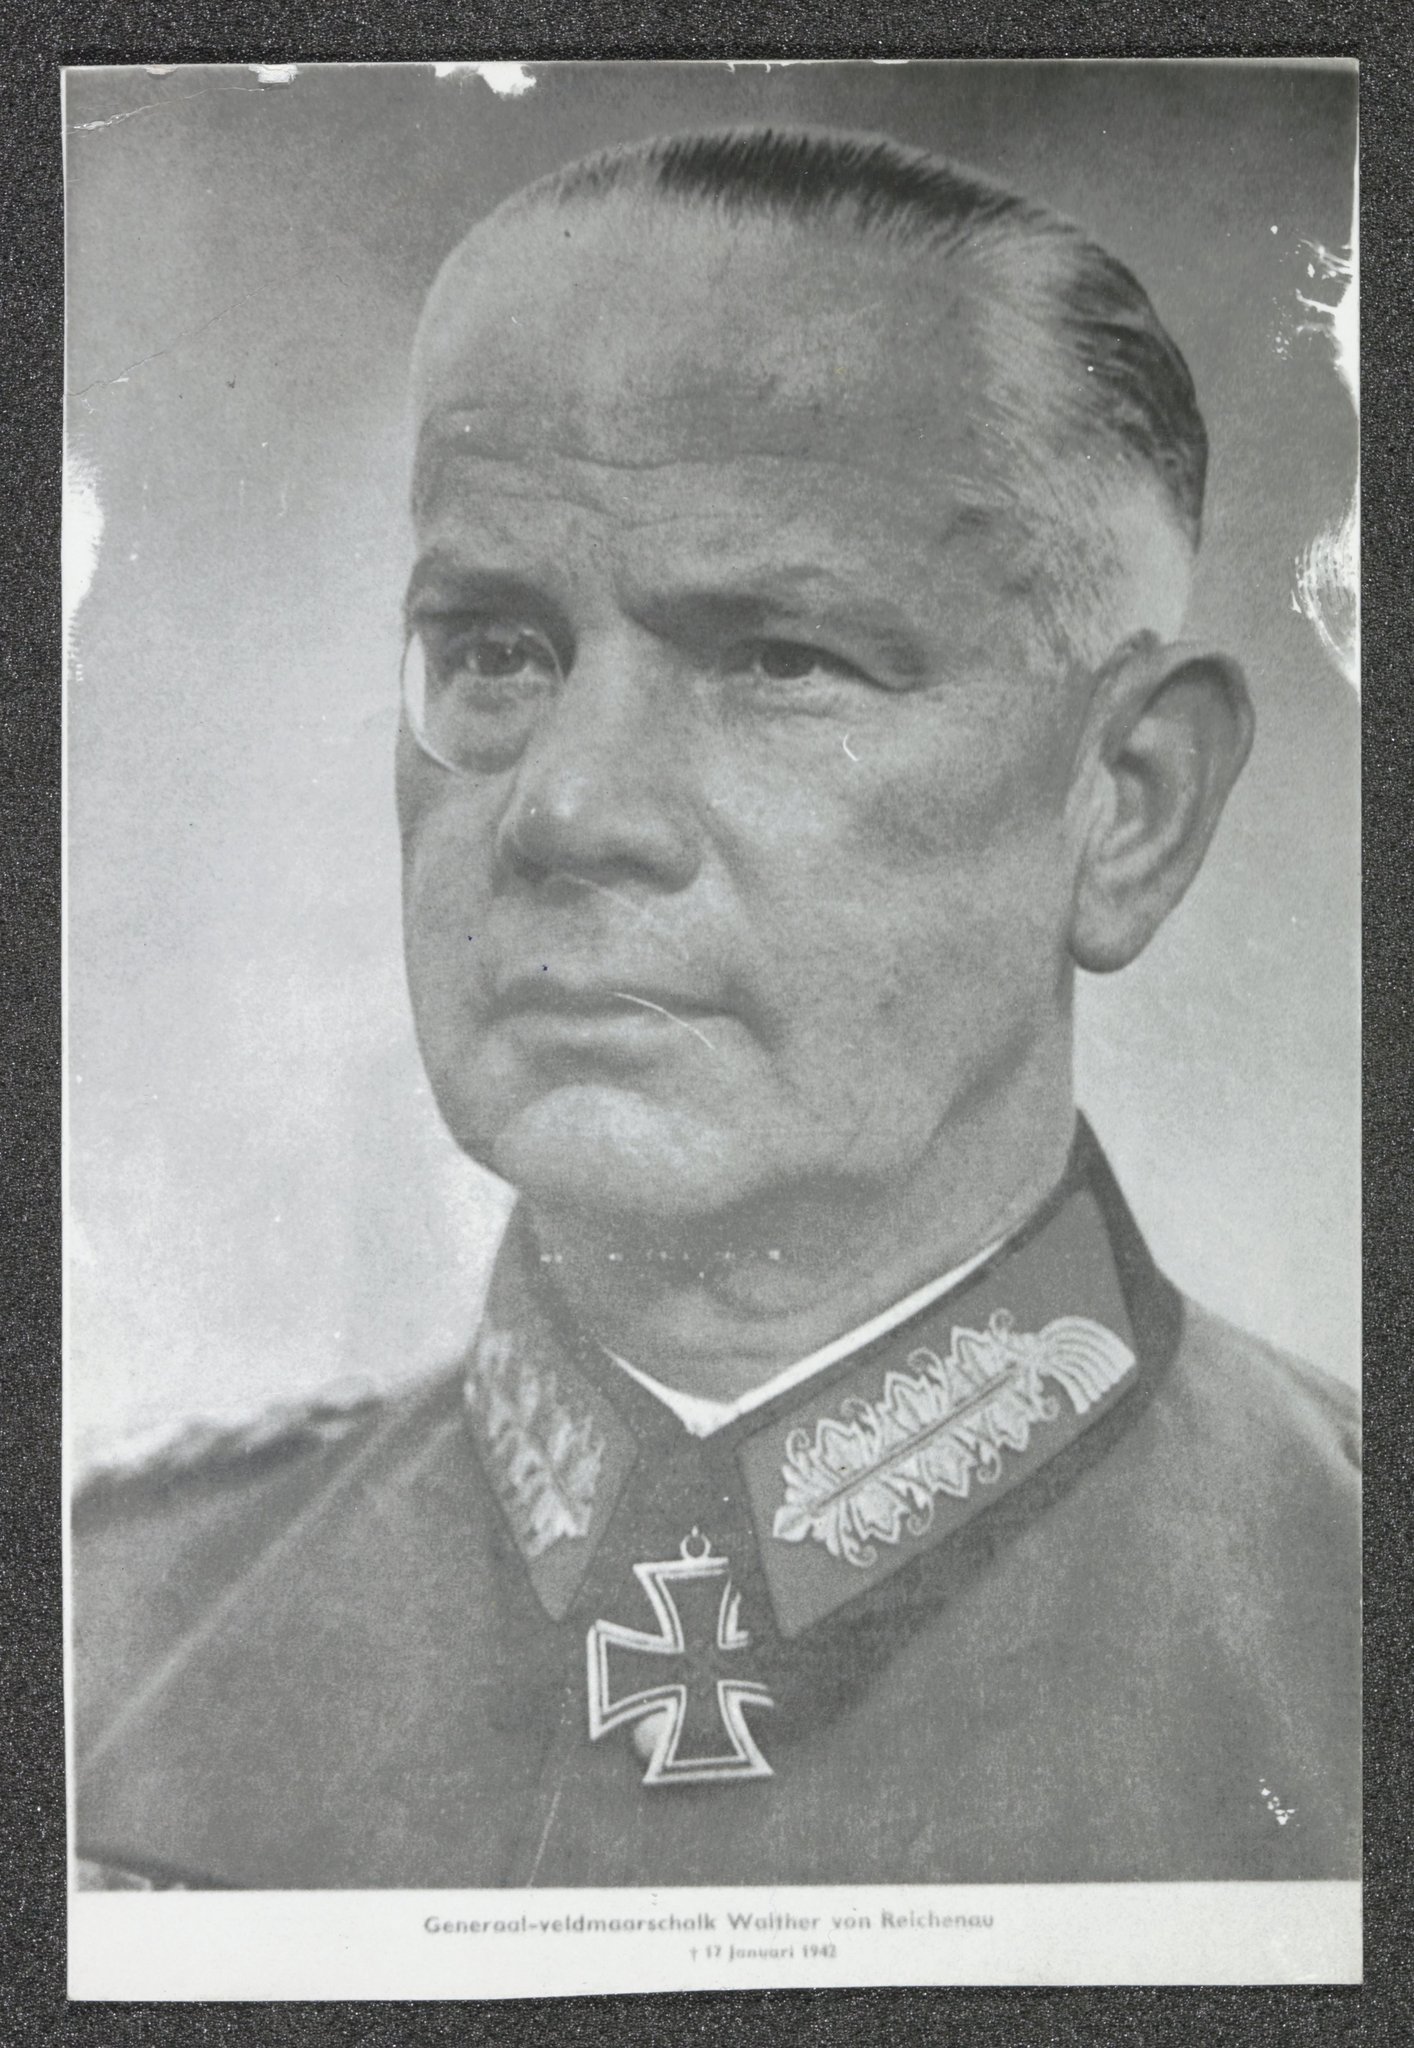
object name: ansichtkaart, prentbriefkaart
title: Portret van generaal veldmaarschalk Walther von Reichenau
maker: Anonymous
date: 1942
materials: photographic support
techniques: gelatin silver print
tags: germany